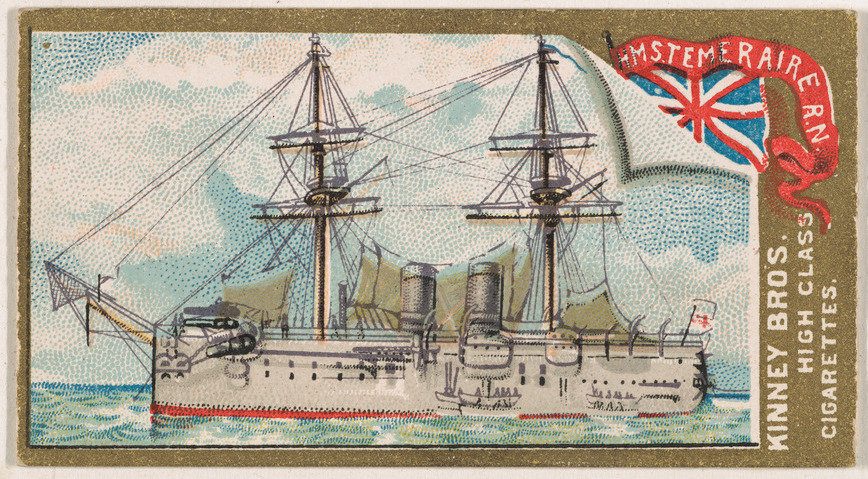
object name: print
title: H.M.S. Temeraire, Royal Navy, from the Naval Vessels of the World series (N226) issued by Kinney Bros.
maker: kinney brothers tobacco company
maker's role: publisher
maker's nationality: american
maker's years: 1869-2011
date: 1889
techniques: color lithograph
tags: navy,flags,ships